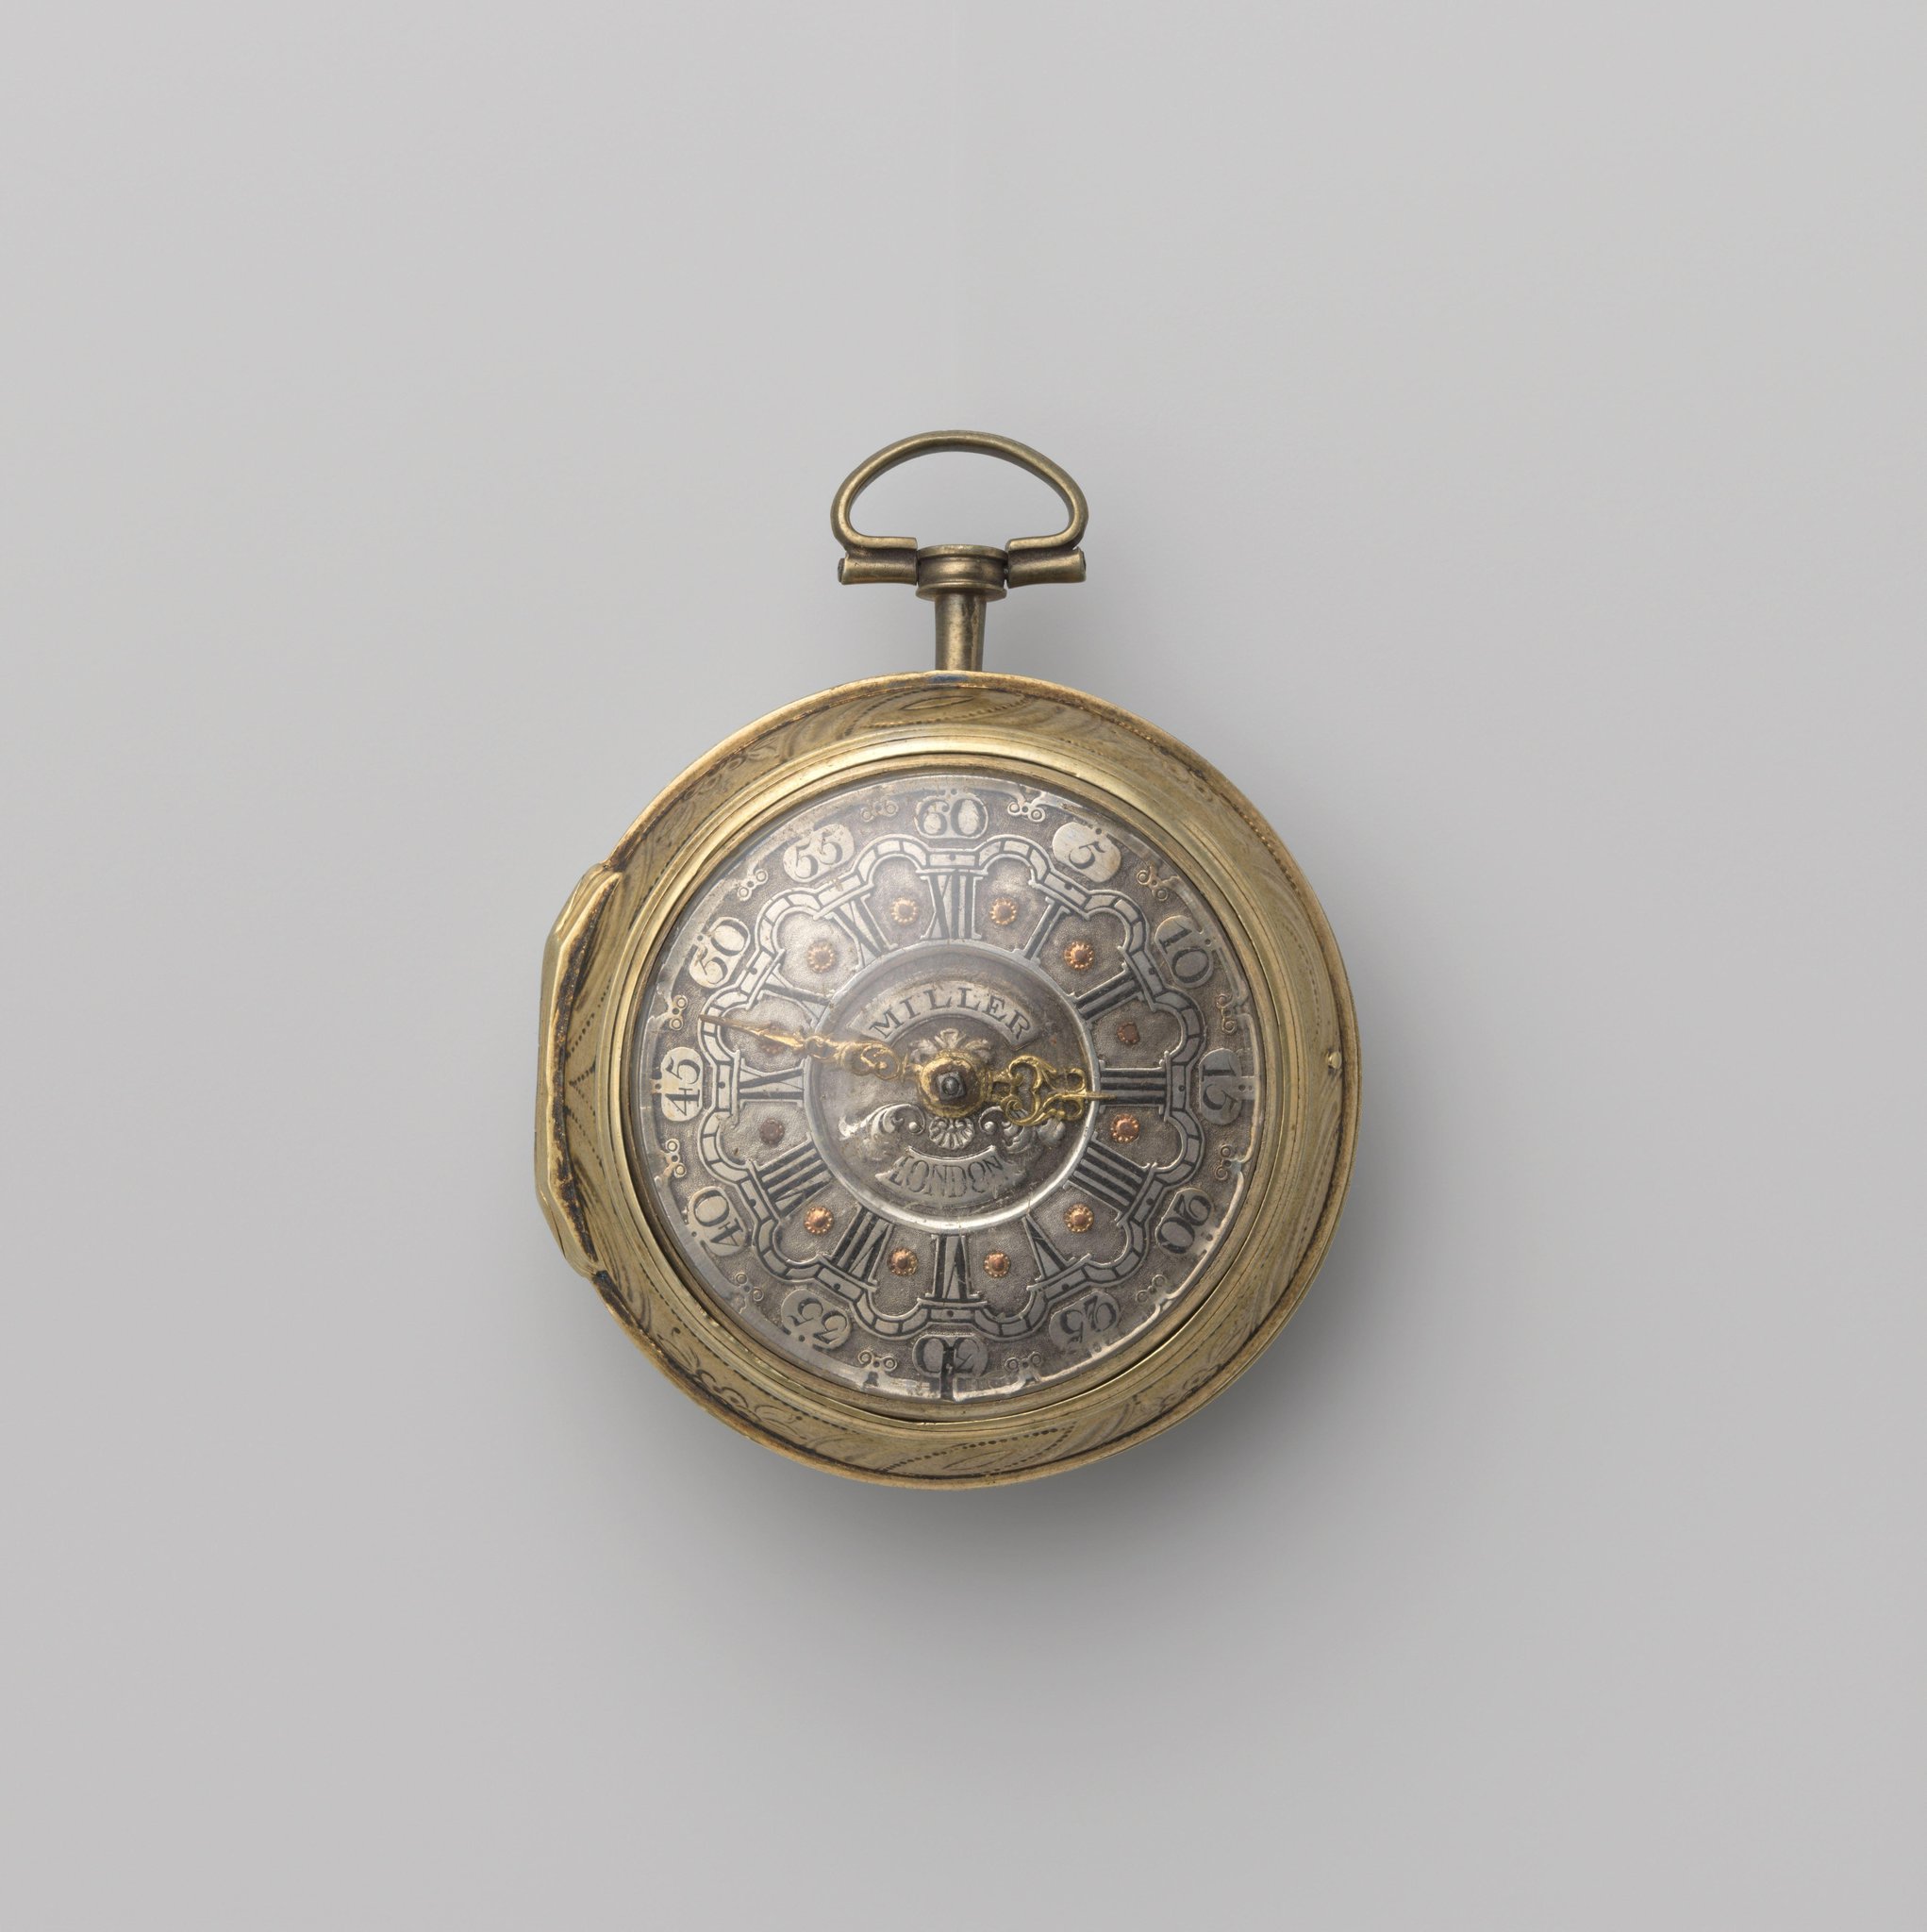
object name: pocket watch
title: Zakhorloge met gedreven voorstelling van Minerva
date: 1763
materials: silver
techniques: gilding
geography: amsterdam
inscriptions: retailer's mark: ‘Hk Gijswijt & Zoon // te Amsterdam’, maker's mark: ‘I . H’, mark: ‘lion passant’, mark: ‘luipaardkop’, date letter: ‘H (=1763)’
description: Verguld zilveren horloge. Wijzerplaat geciseleerd en getekend: Miller London. Werk op de platine getekend: Tho:s Miller, London 1224. Gedreven, verguld zilveren buitenkast met de voorstelling van een bezoek van Minerva aan twee oude lieden.